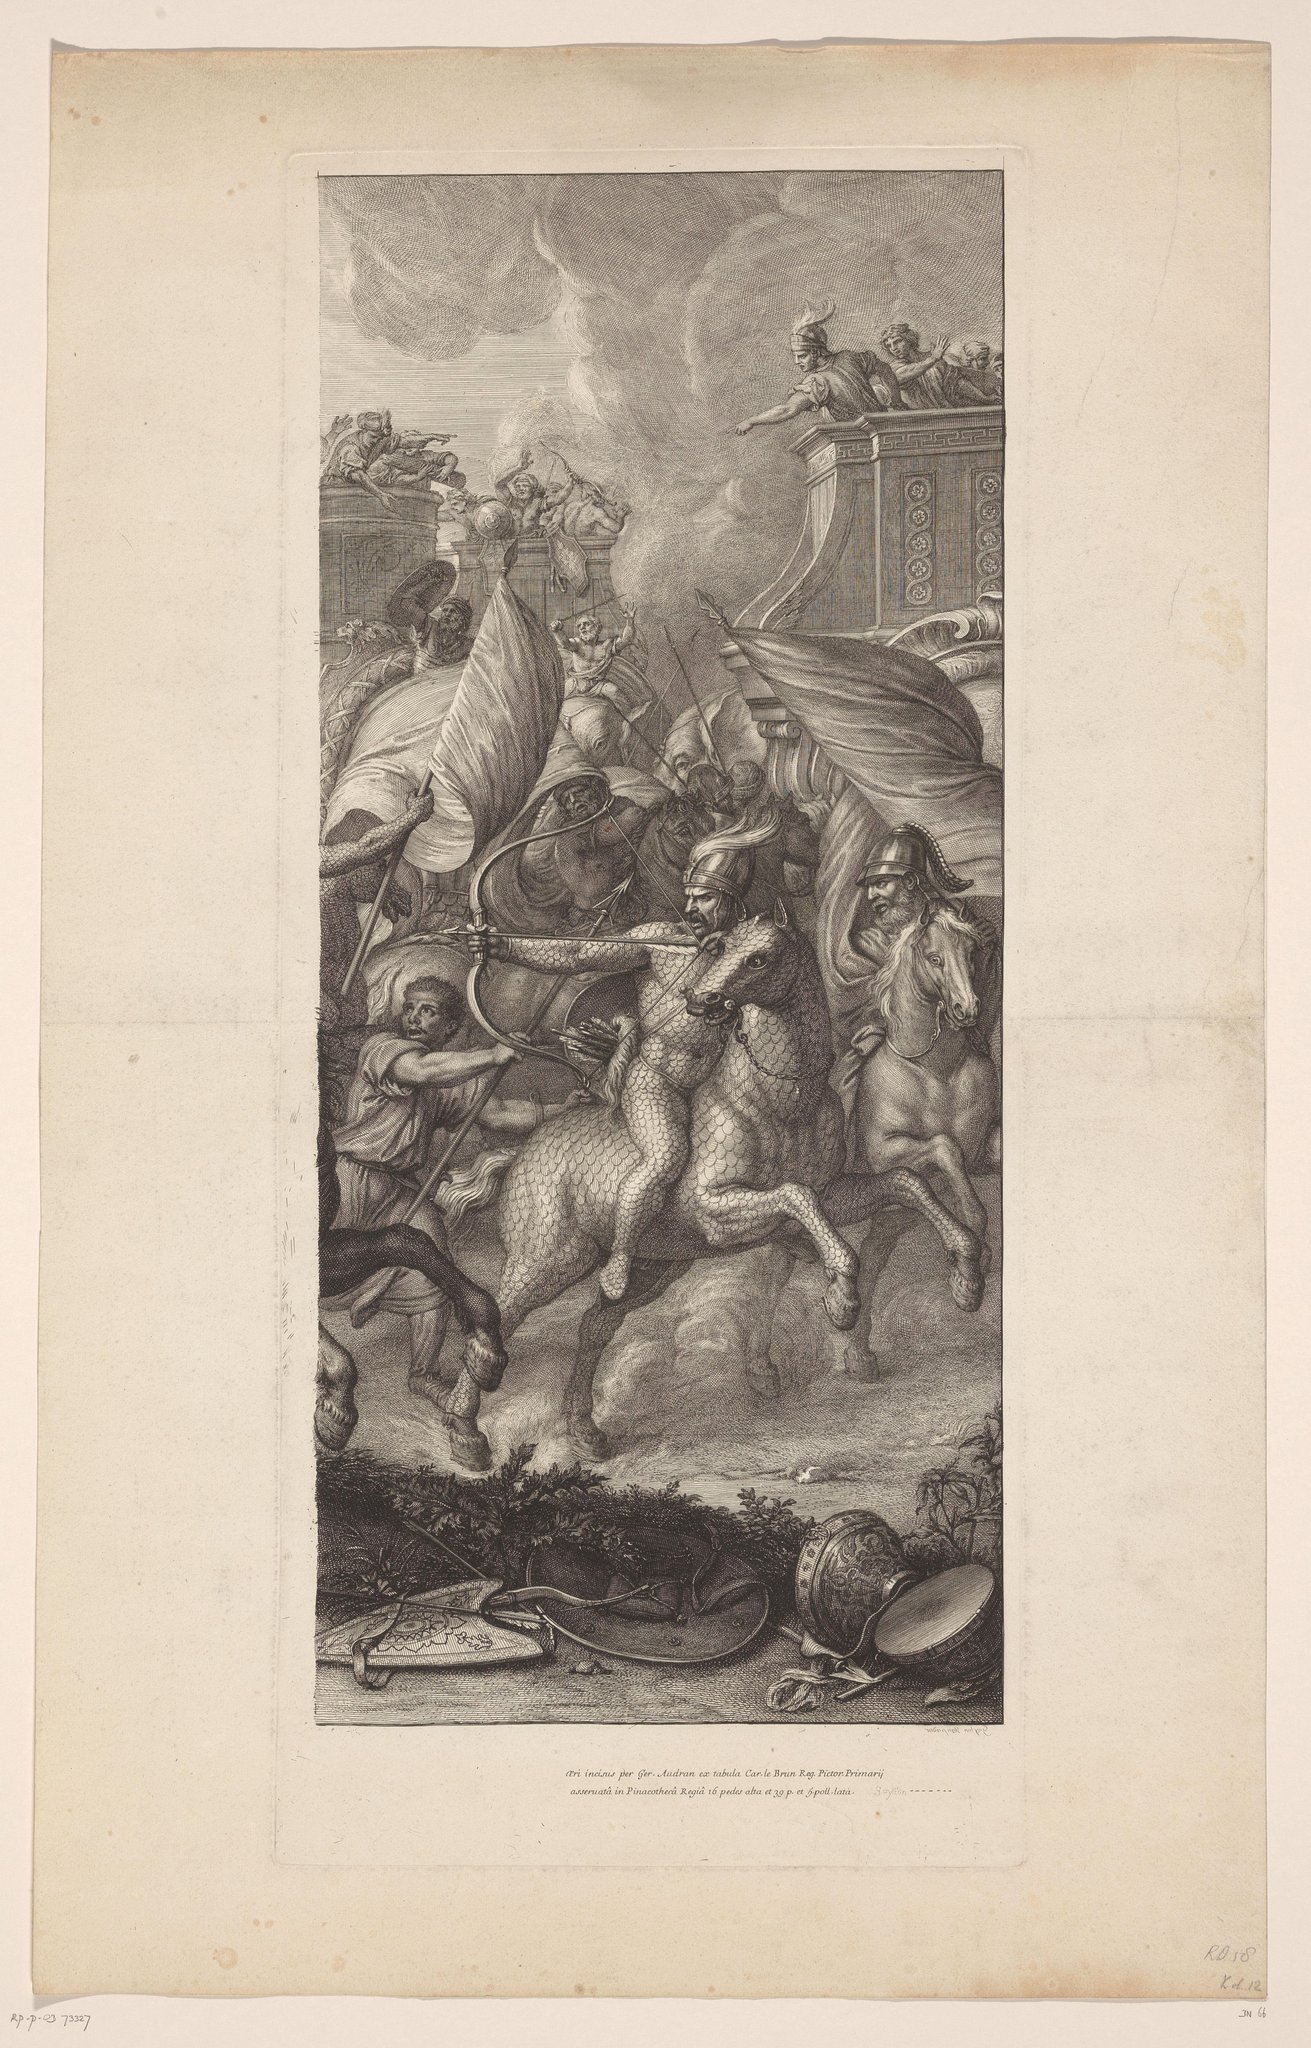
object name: print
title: Slag bij Arbela (plaat 4)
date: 1674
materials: paper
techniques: engraving, etching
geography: paris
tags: persia, alexander fighting against darius at issus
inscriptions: collector's mark: Lugt 1838, inscription: ‘RD 58’, collector's mark: Lugt 240, inscription: ‘Kd. 12’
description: Derde blad (van links naar rechts) van een prent gedrukt van vier platen.